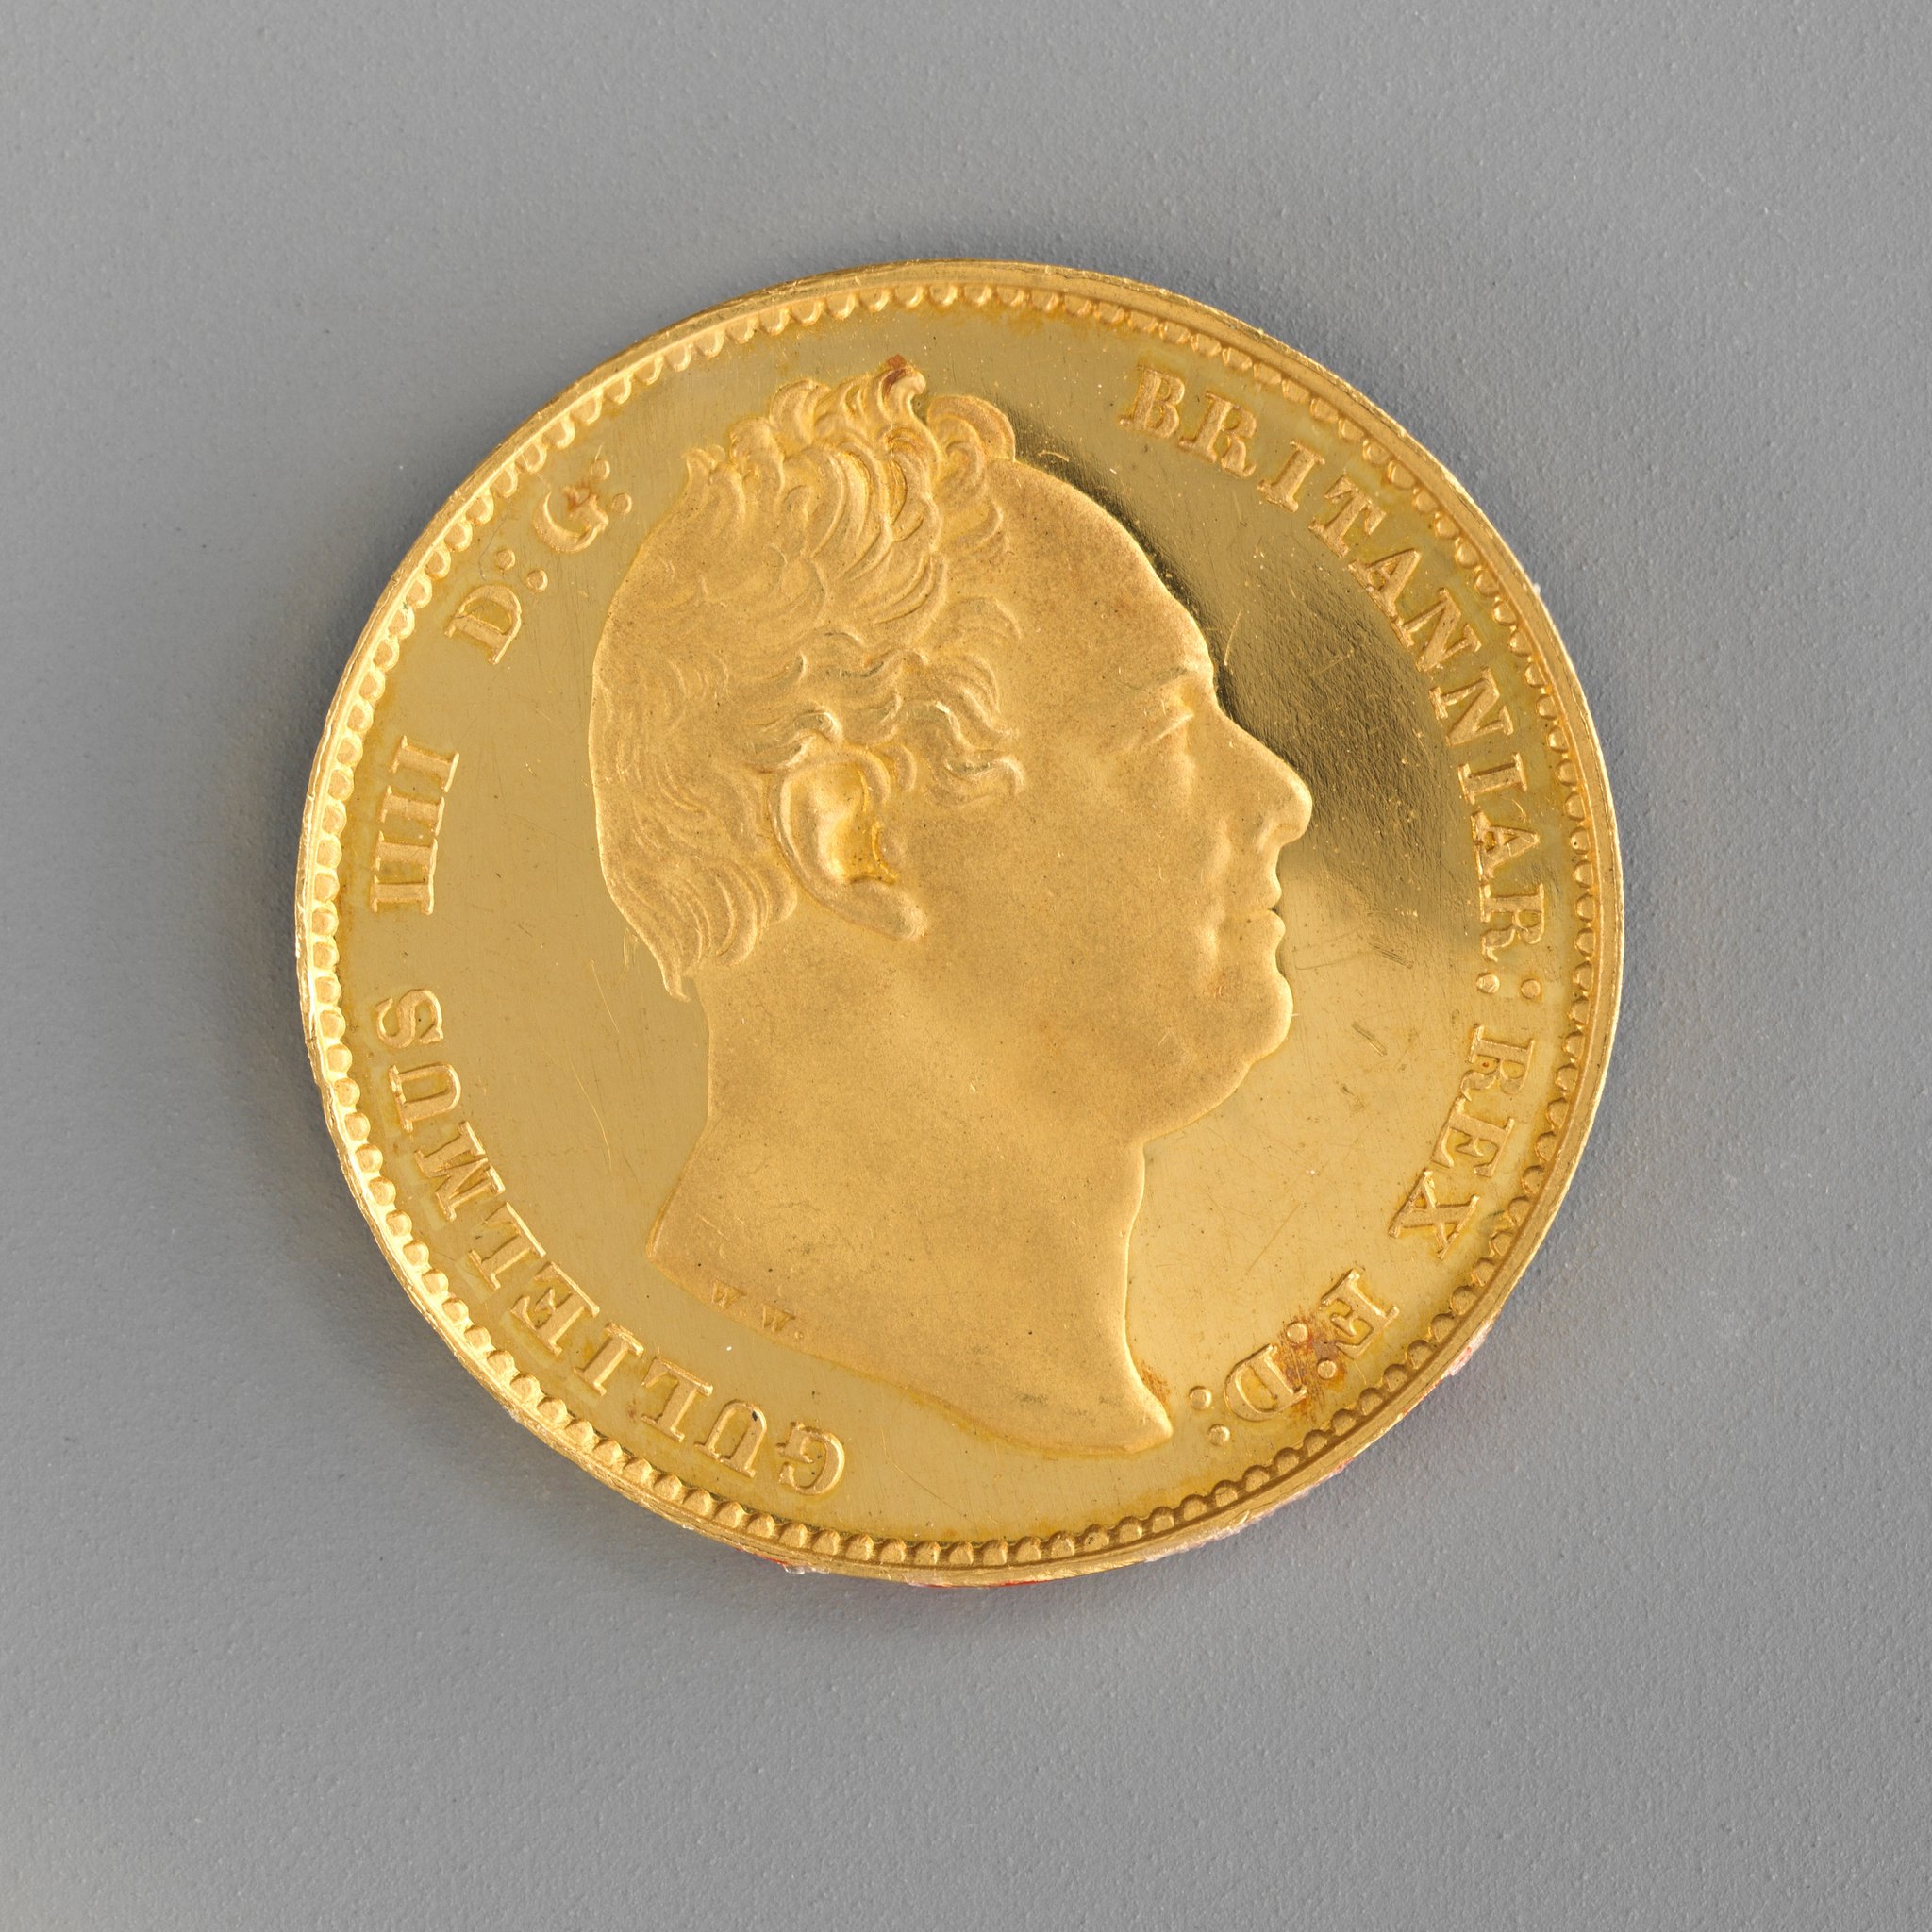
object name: proof sovereign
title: Proof sovereign of William IV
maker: william wyon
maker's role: artist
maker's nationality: british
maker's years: 1795-1851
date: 1831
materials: gold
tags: men,profiles,coat of arms